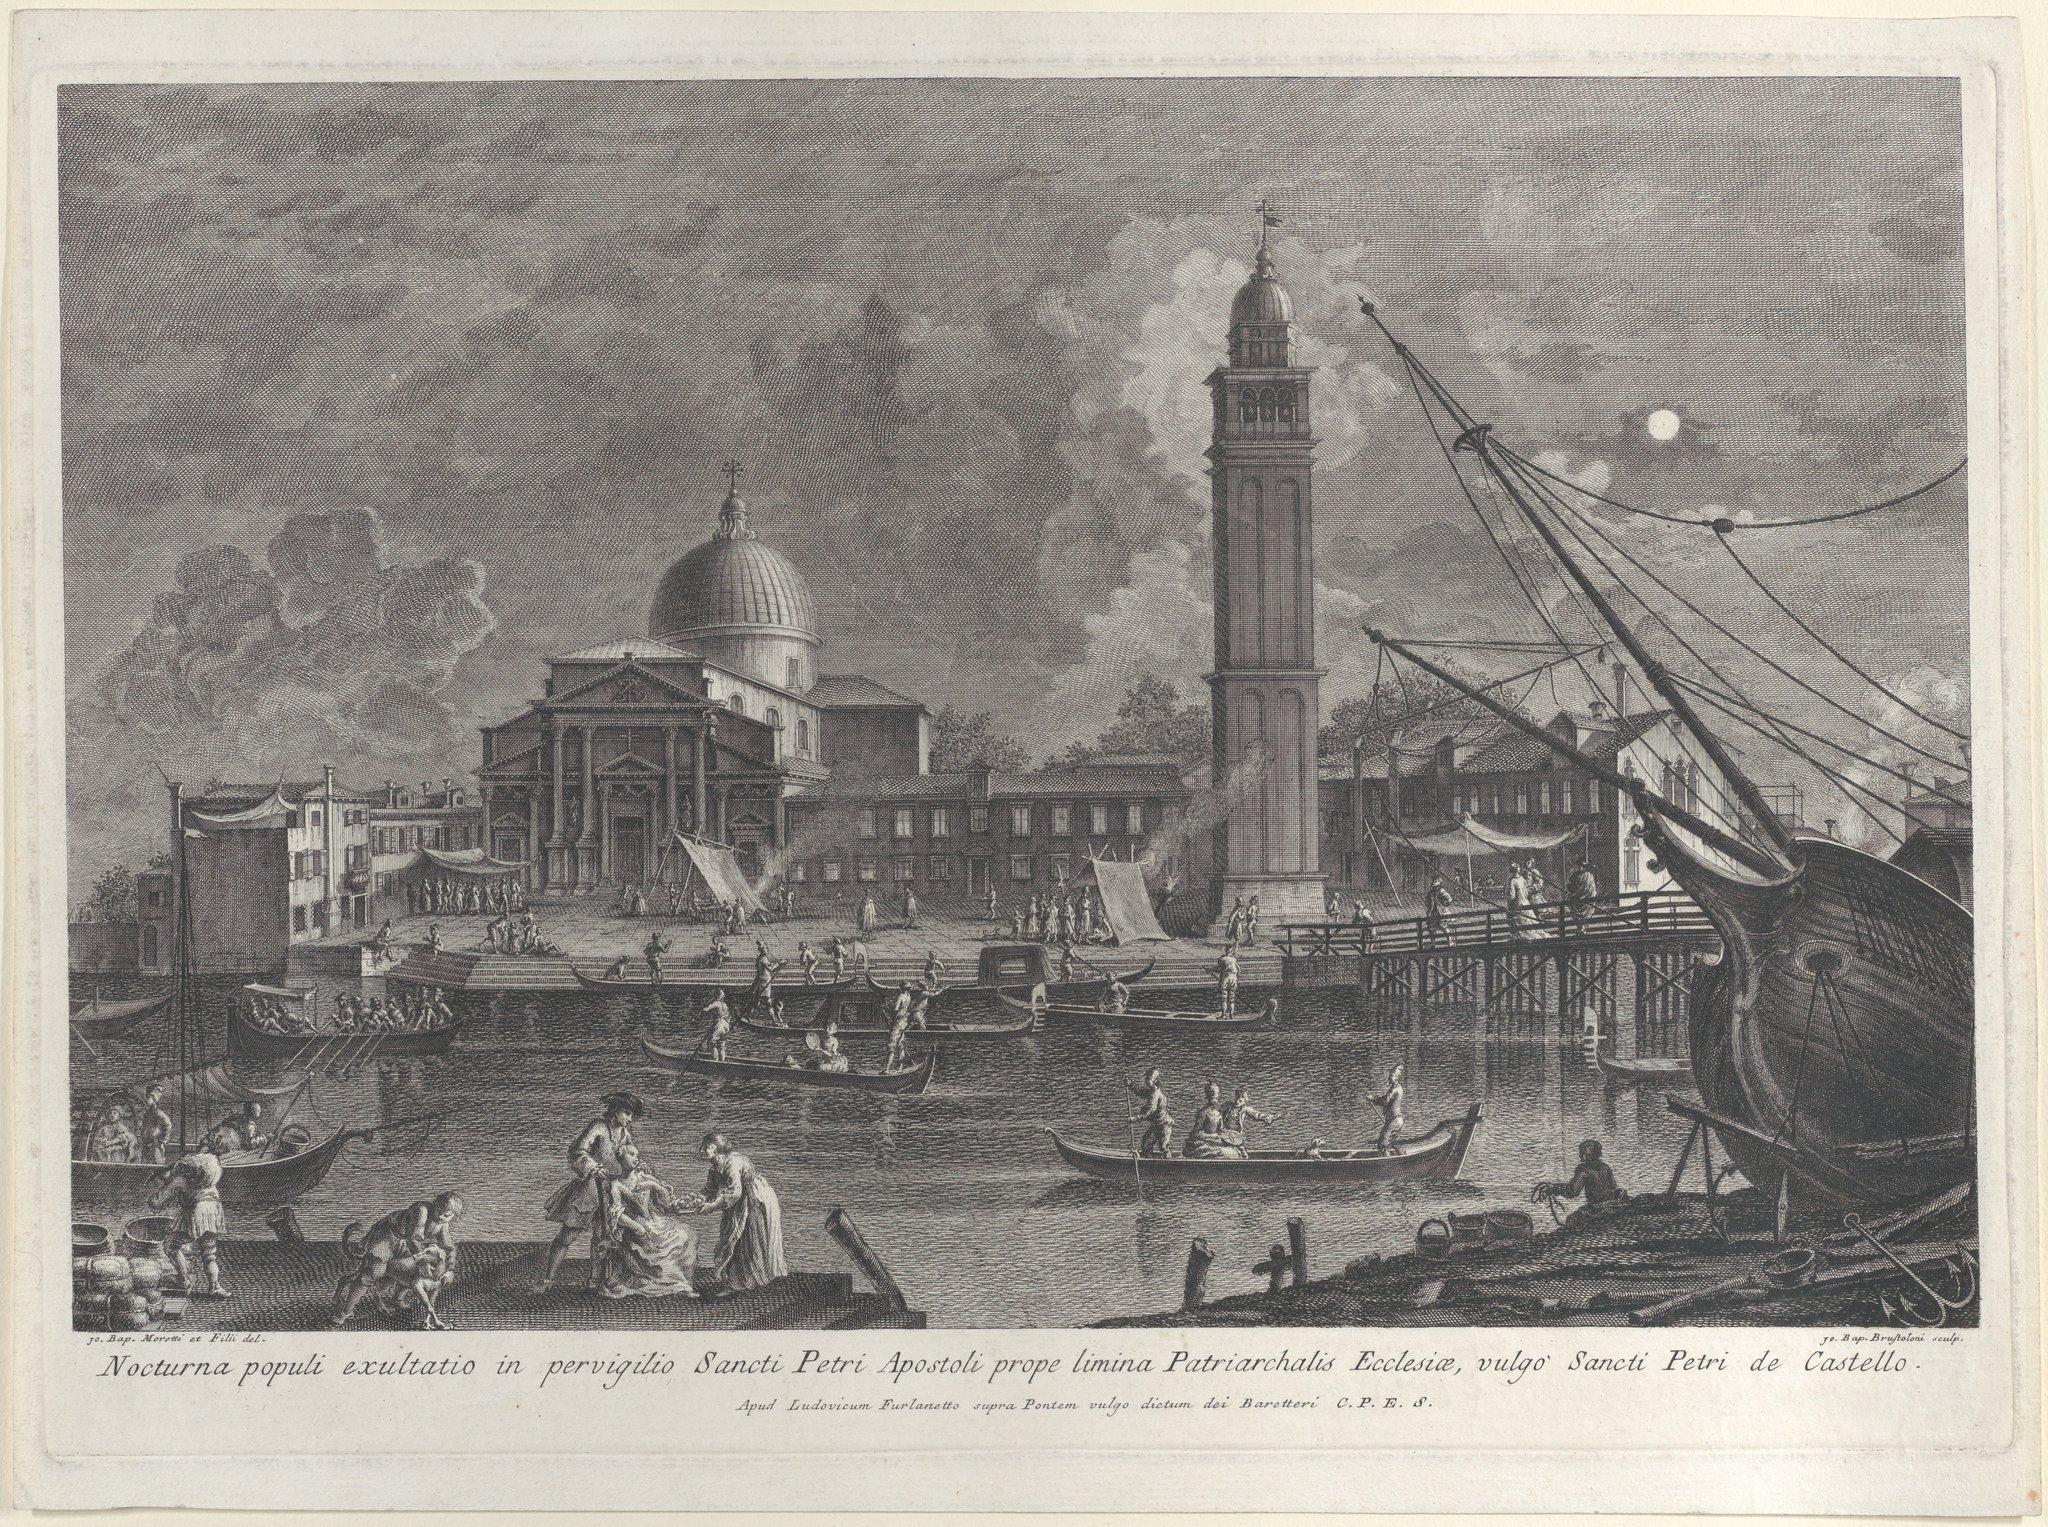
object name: print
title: Nocturnal view of the gondolas' procession in front of the Basilica of San Pietro di Castello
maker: giovanni battista brustolon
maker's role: artist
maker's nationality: italian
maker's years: 1712-1796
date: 1763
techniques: etching